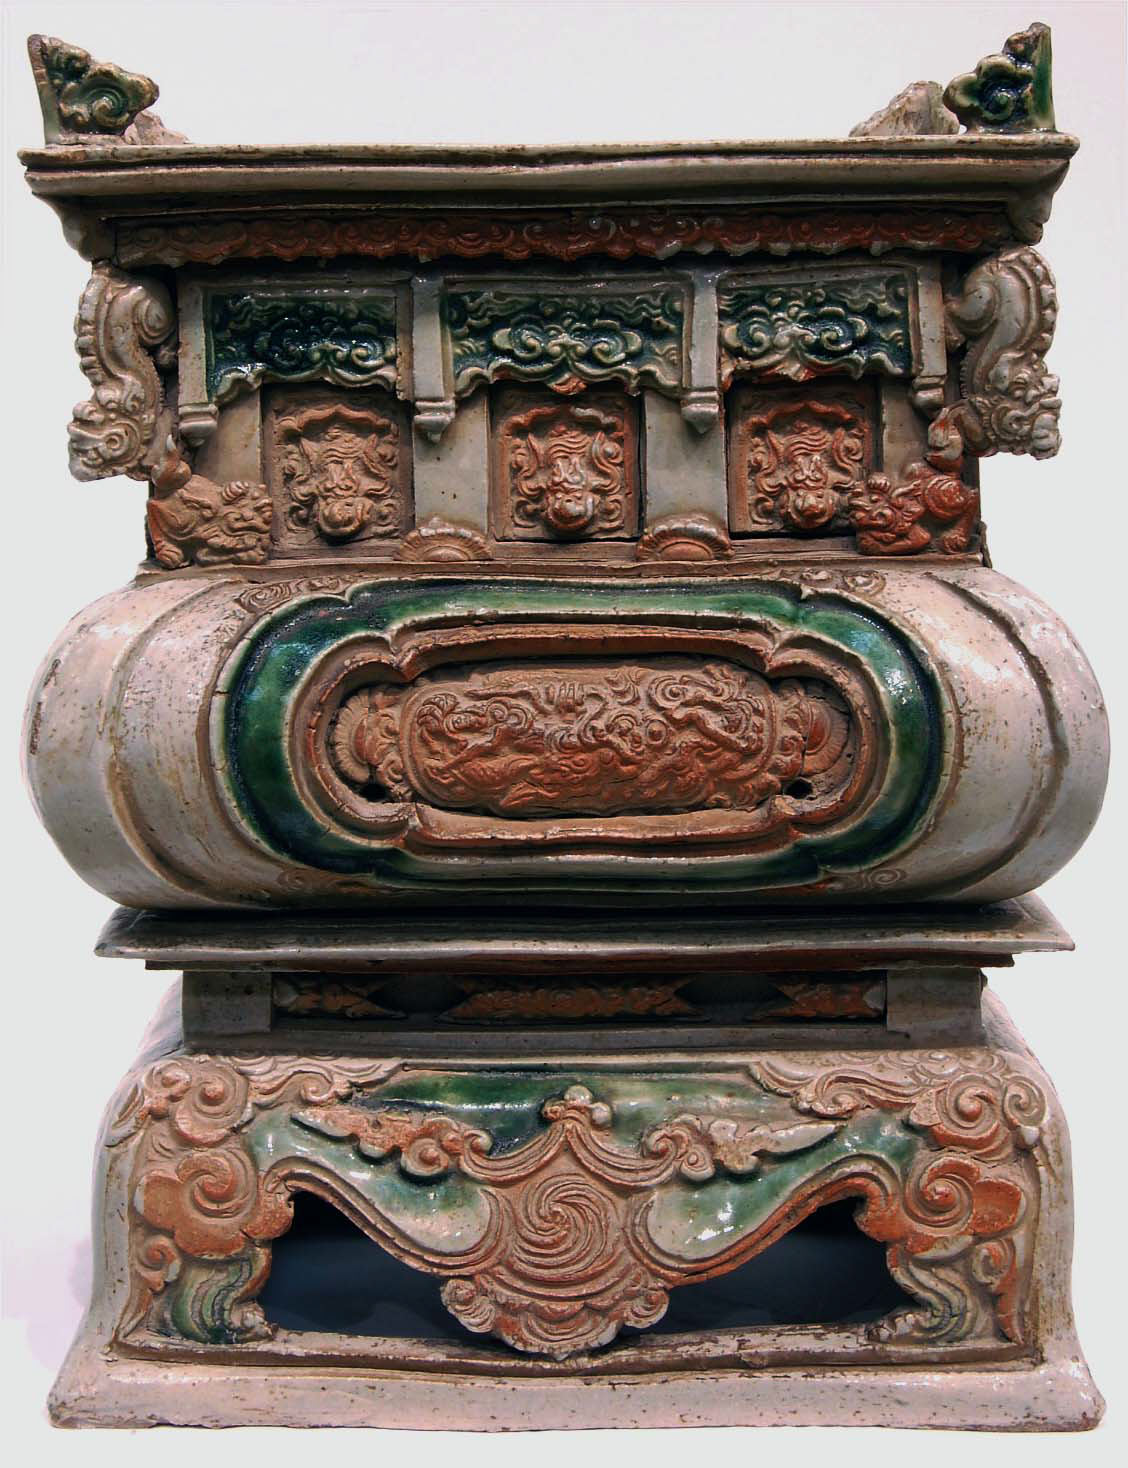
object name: incense burner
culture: vietnamese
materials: biscuit, stoneware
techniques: appliqué, firing, glazing, molding